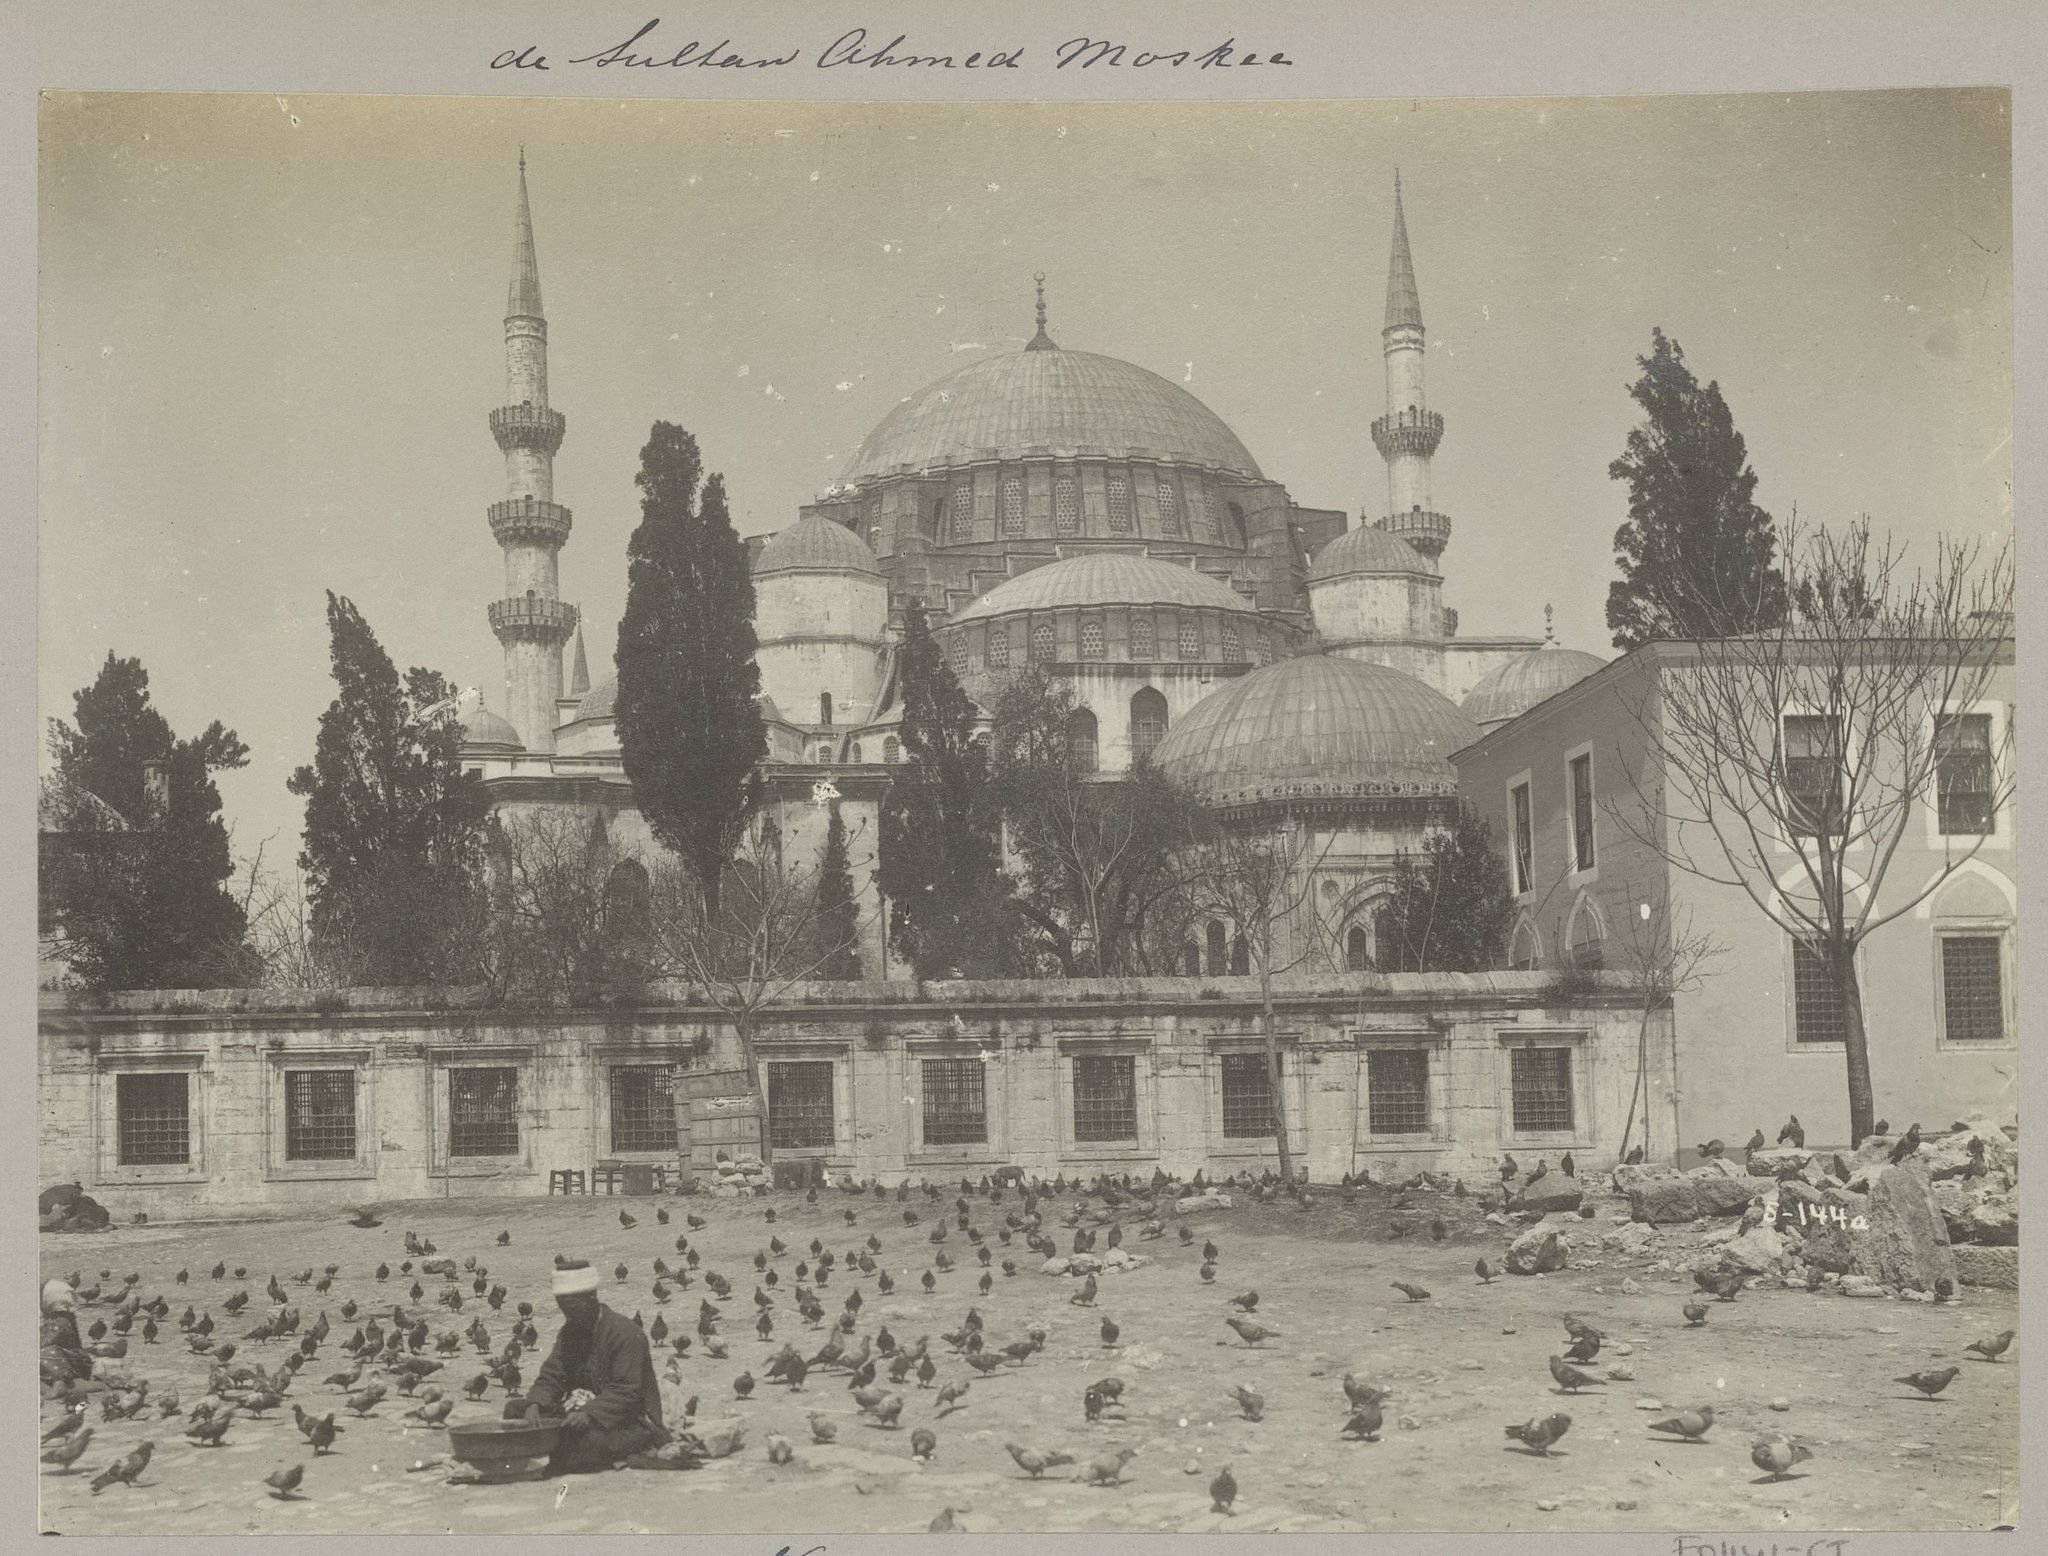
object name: photograph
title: Sultan Ahmetmoskee in Istanbul met op de voorgrond een plein met duiven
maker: Anonymous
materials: photographic support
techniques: gelatin silver print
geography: istanbul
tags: temple, shrine ~ islam, mohammedanism, doves, pigeons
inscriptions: number: ‘5-144a’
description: Onderdeel van Fotoalbum van een reis door Zuid-Europa en het Midden-Oosten.